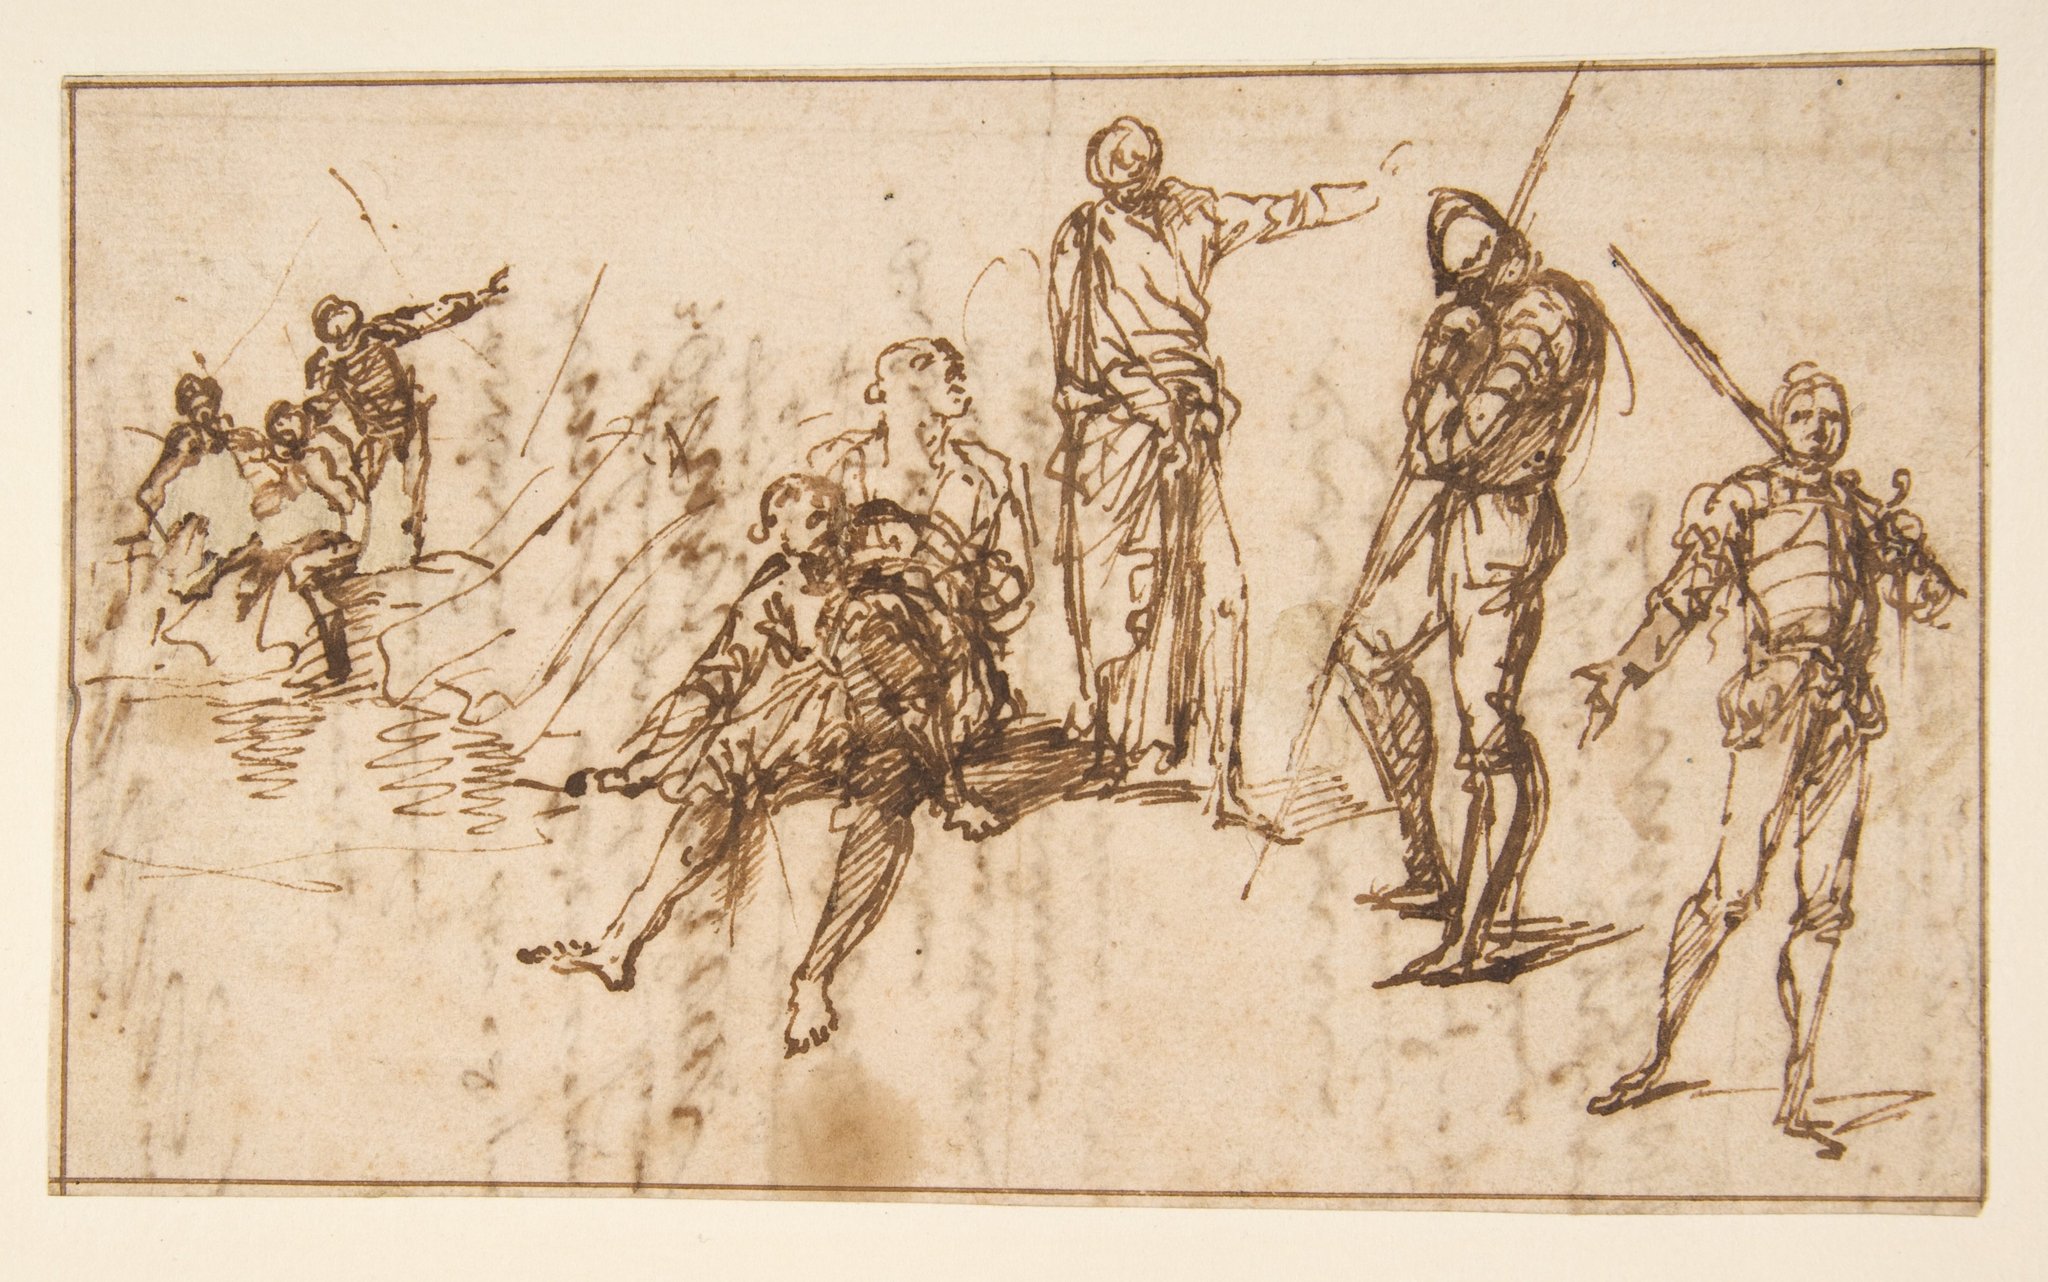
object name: drawing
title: Two Standing Soldiers and Six other Figures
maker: salvator rosa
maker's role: artist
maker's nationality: italian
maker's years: 1615-1673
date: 1615-1673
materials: ink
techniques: pen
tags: human figures,soldiers